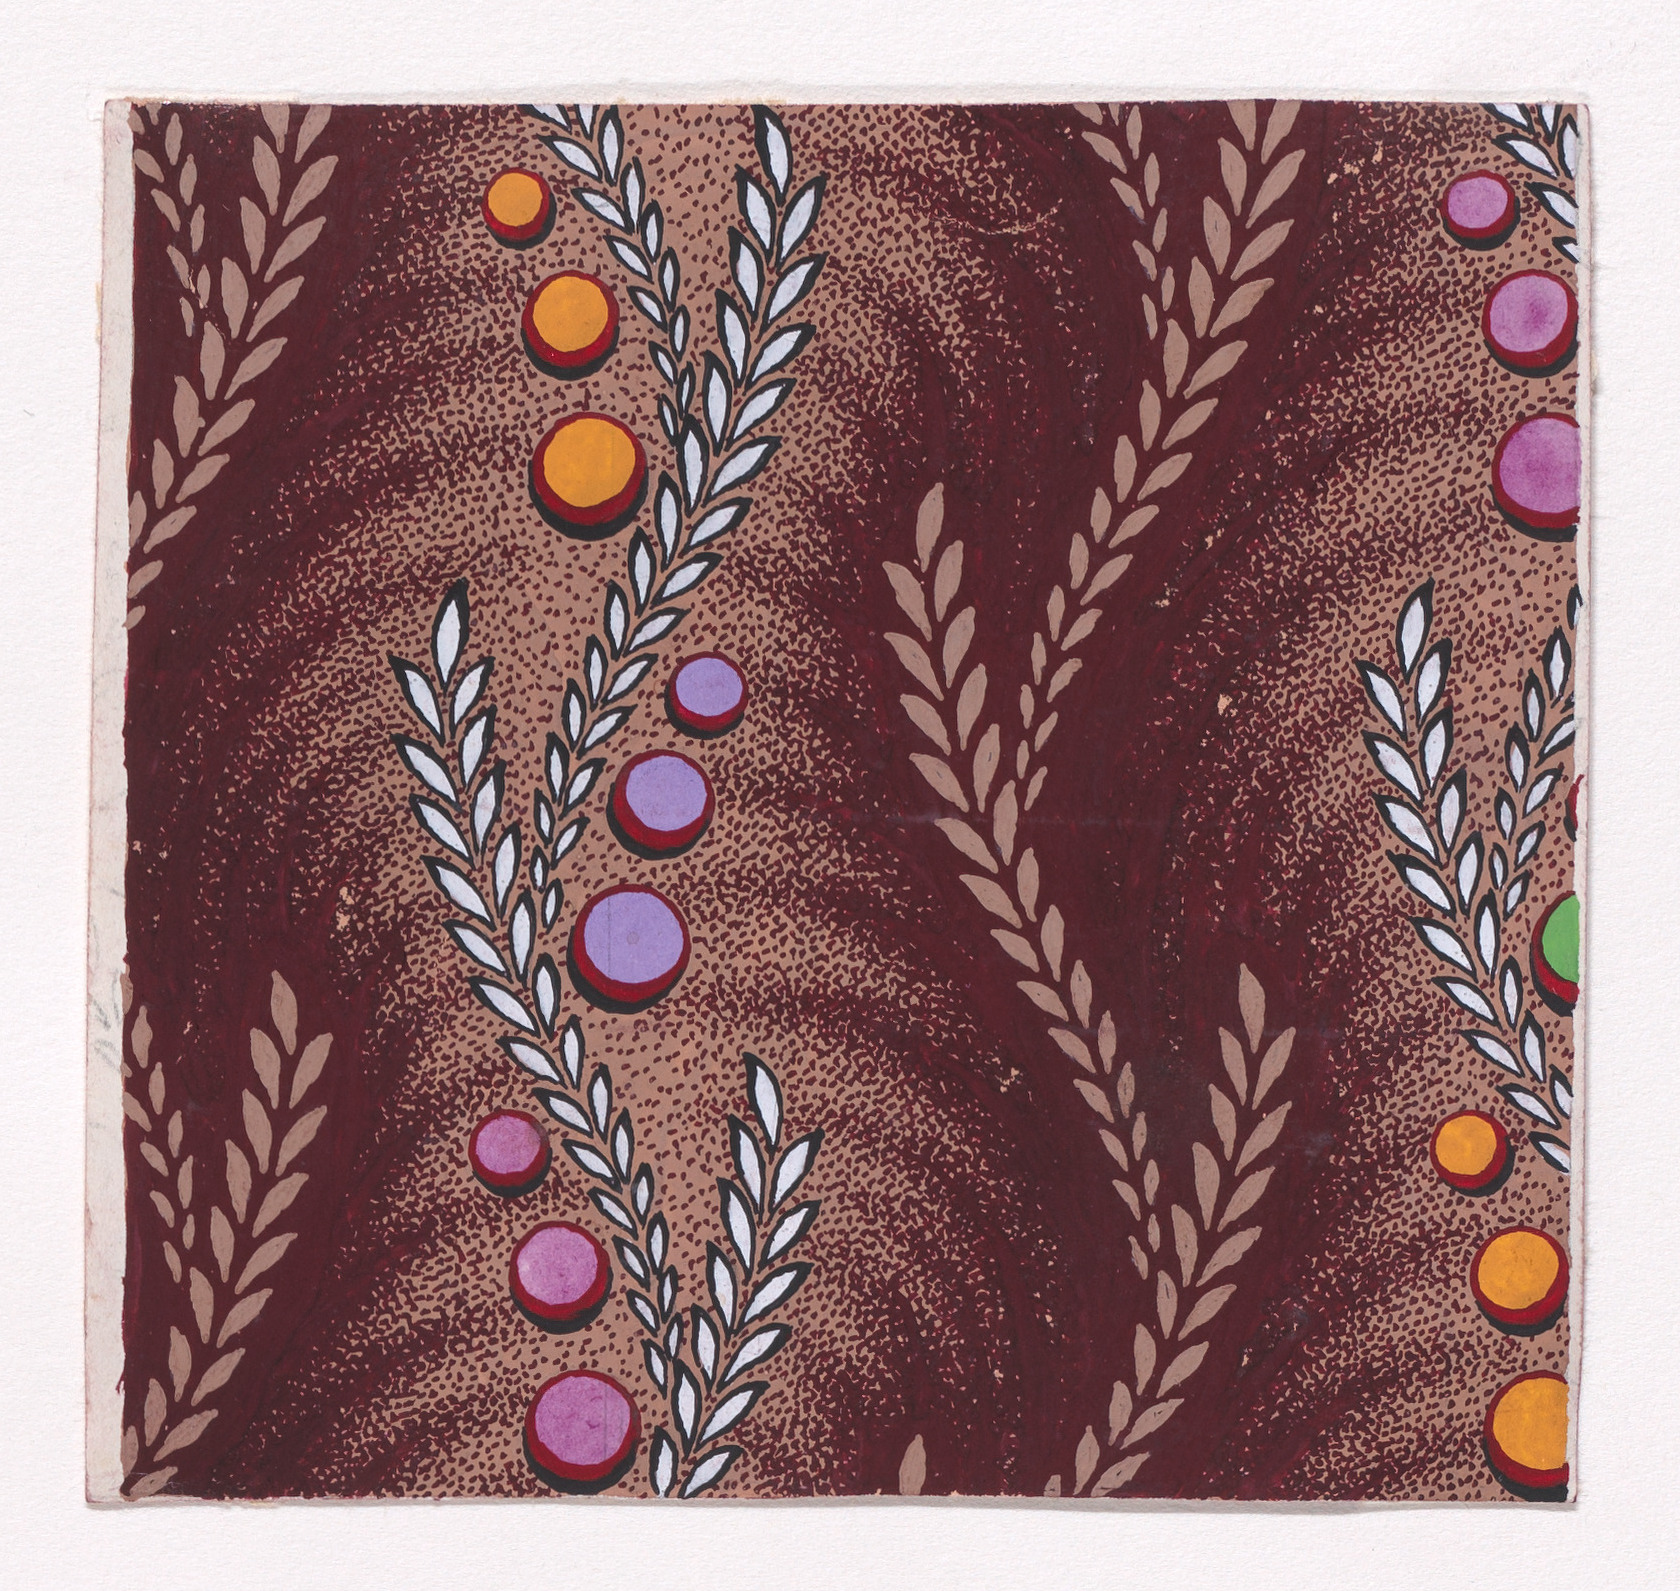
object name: drawing ornament architecture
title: Textile Design with Alternating Vertical Stripes of Undulating Wheat Ears and Undulating Wheat Ears with Circles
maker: anonymous, alsatian, 19th century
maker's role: artist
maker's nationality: alsatian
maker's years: 1800-1900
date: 1840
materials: gouache